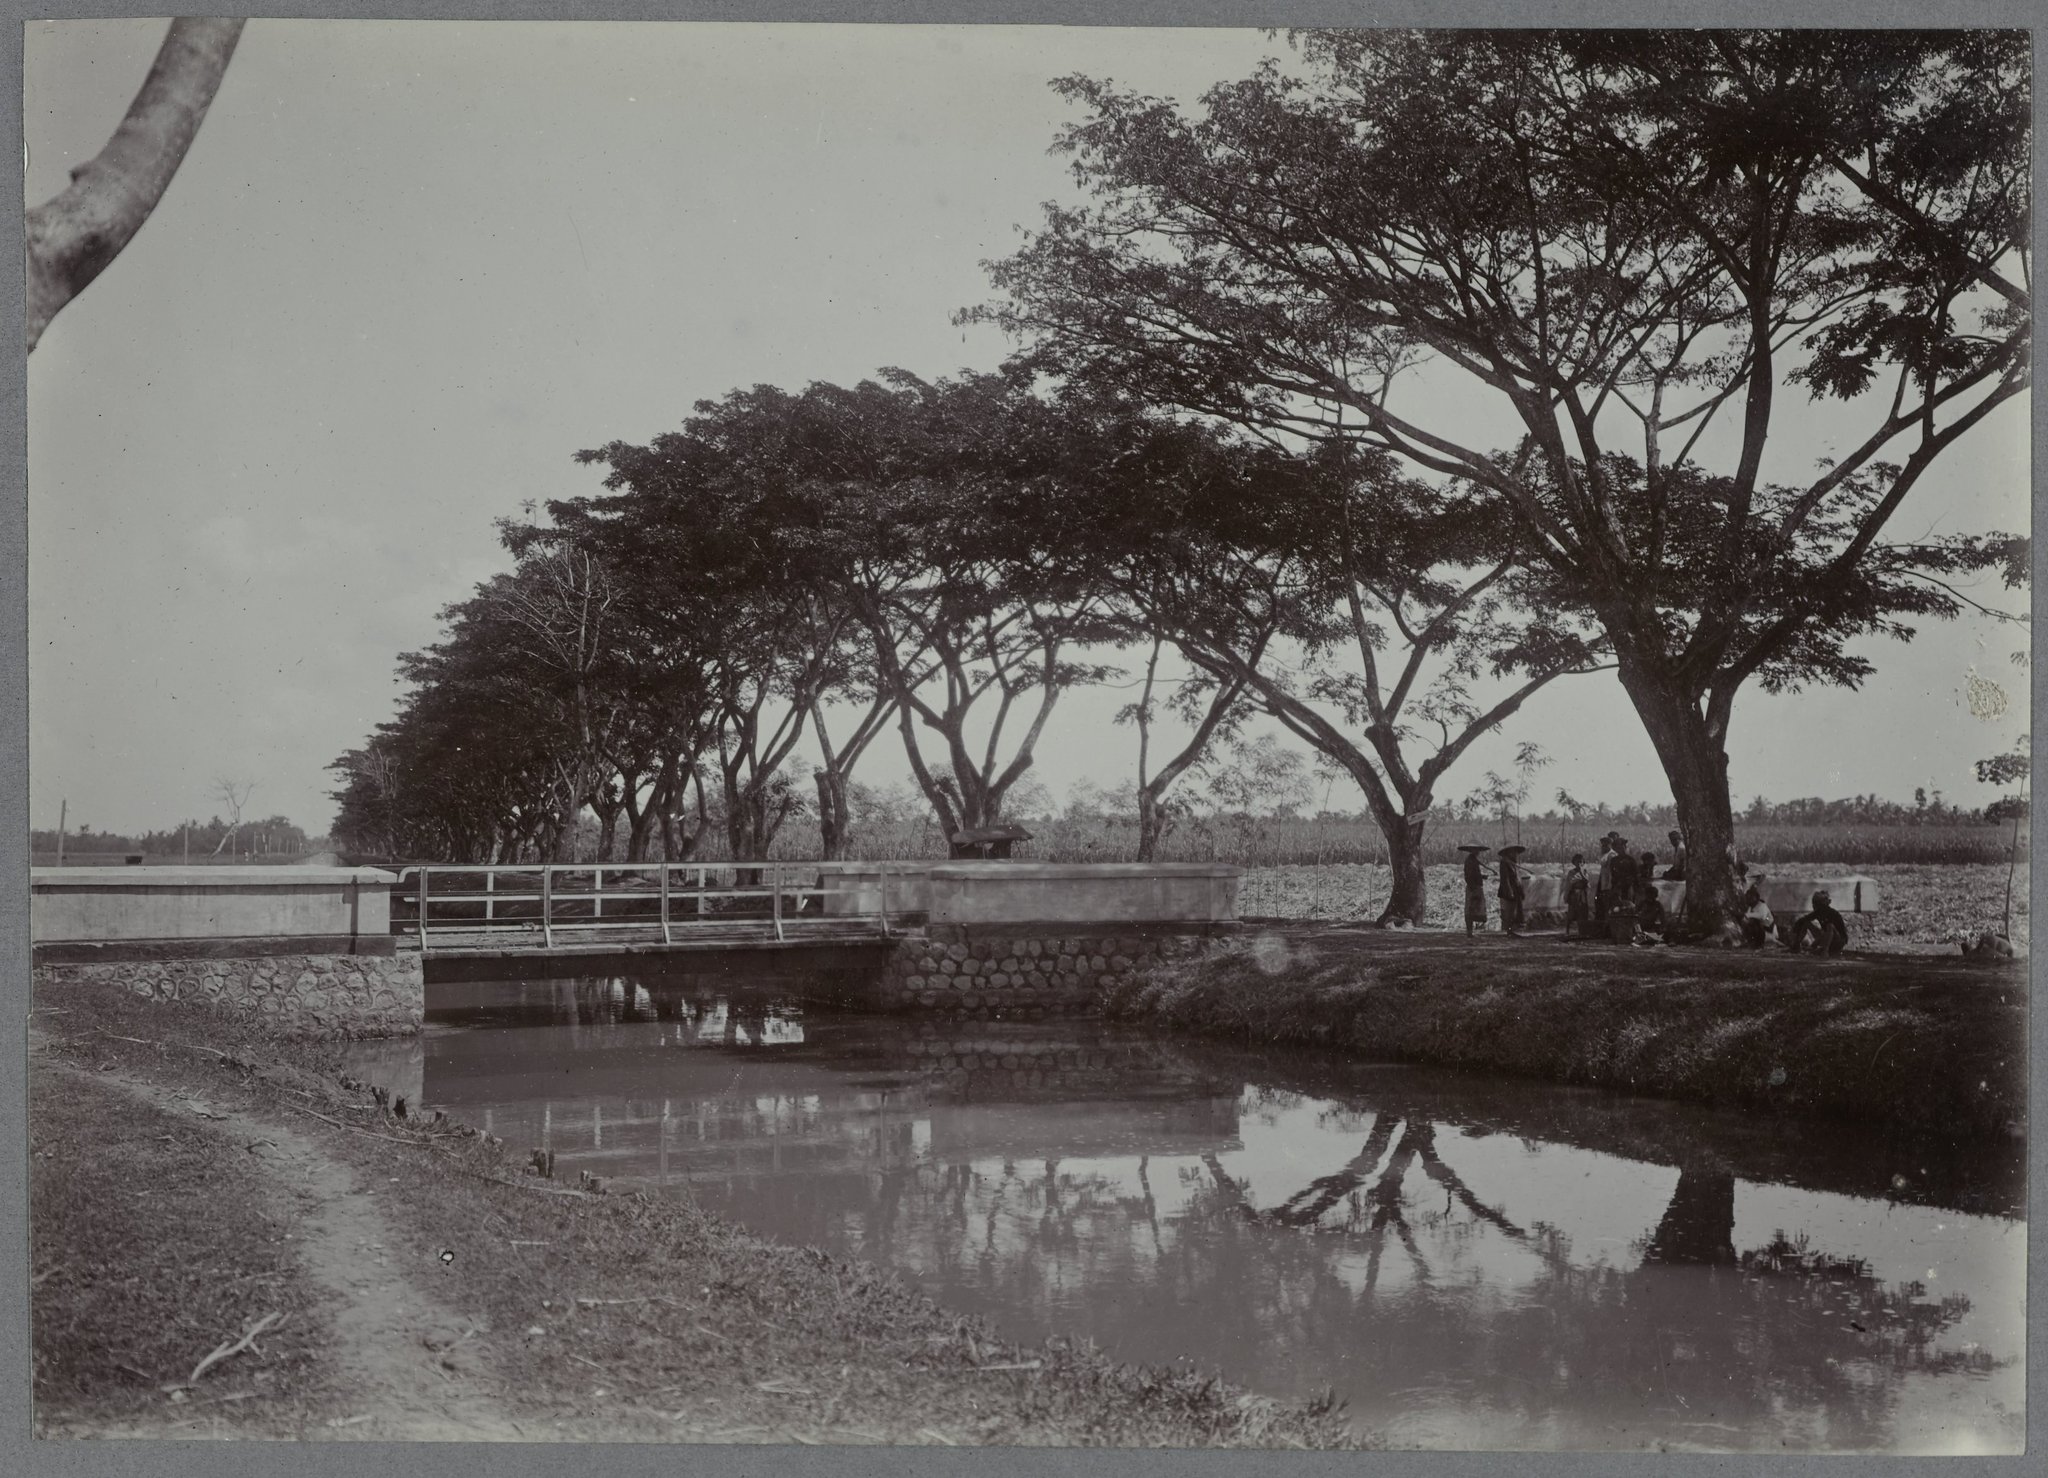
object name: photograph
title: Brug over een kanaal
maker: Anonymous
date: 1900-1919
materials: photographic support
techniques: collodion silver print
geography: comal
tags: colonial system, plantation, (non-fruit) products of plants or trees: sugarcane, bridge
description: Een brug over een kanaal. Onderdeel van het fotoalbum van de Tjomal suikerfabriek in de periode ca. 1900-1919.